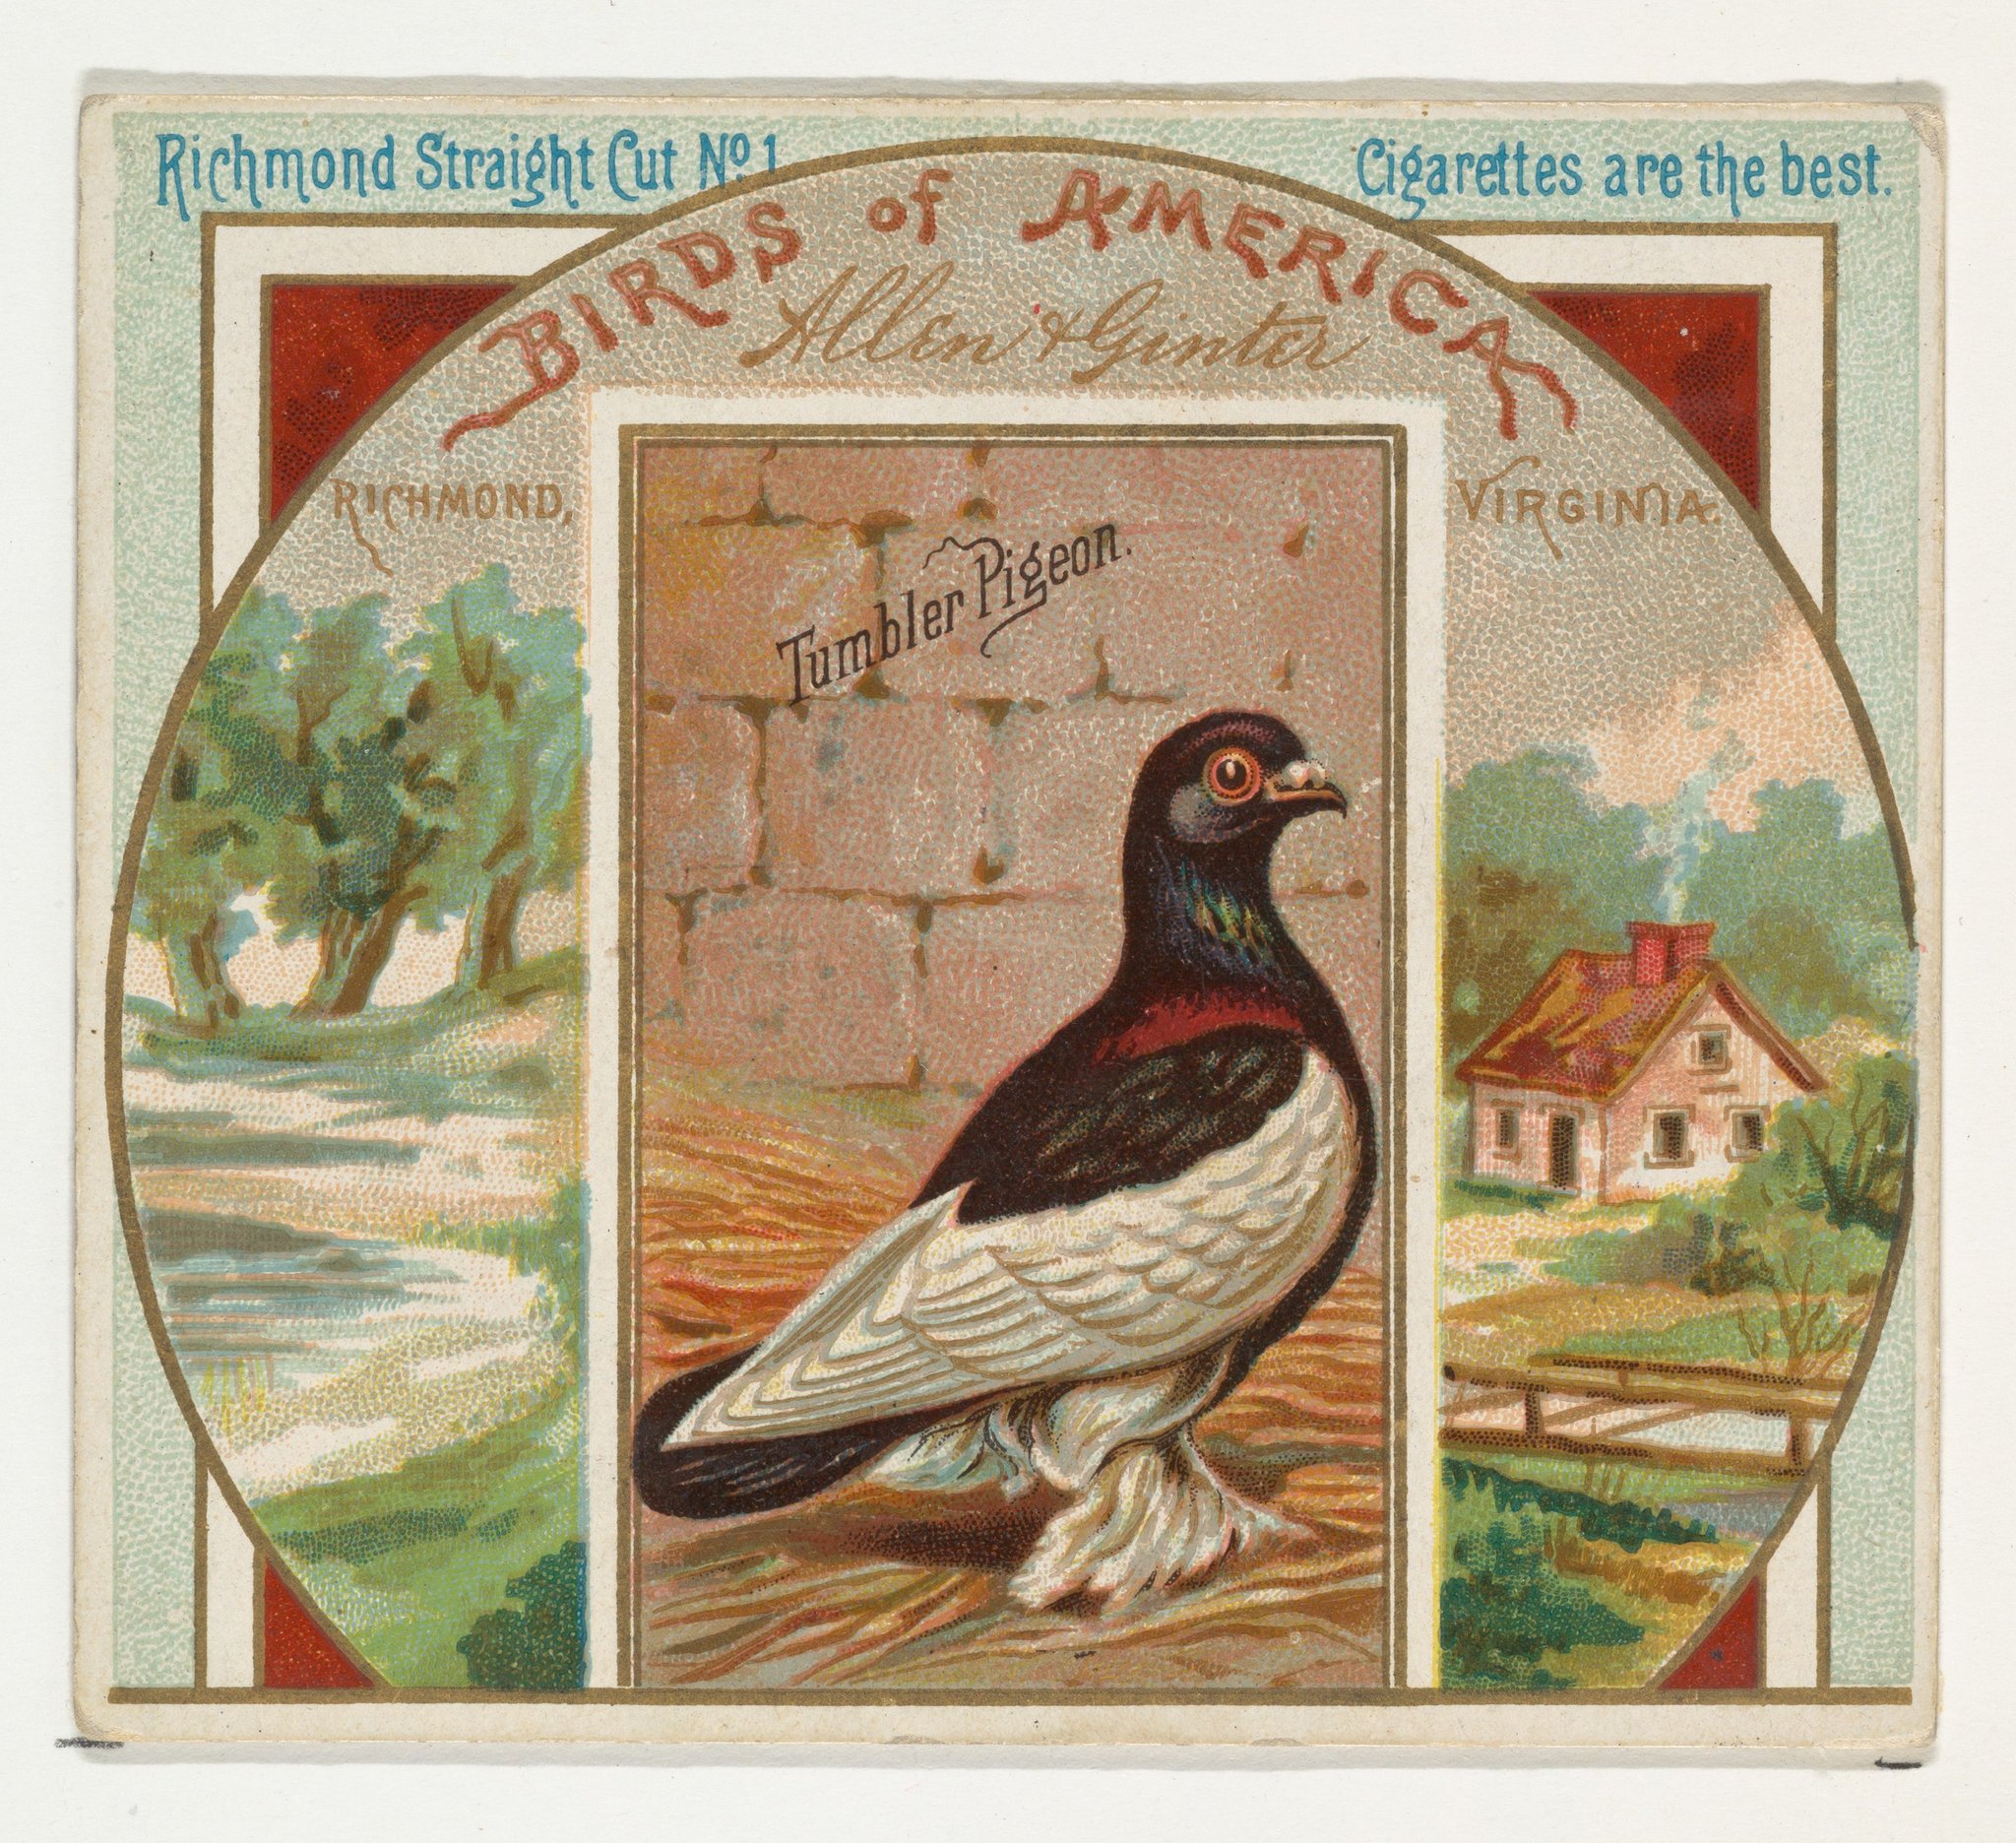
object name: print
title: Tumbler Pigeon, from the Birds of America series (N37) for Allen & Ginter Cigarettes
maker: allen & ginter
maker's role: publisher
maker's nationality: american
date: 1888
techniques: color lithograph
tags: pigeons